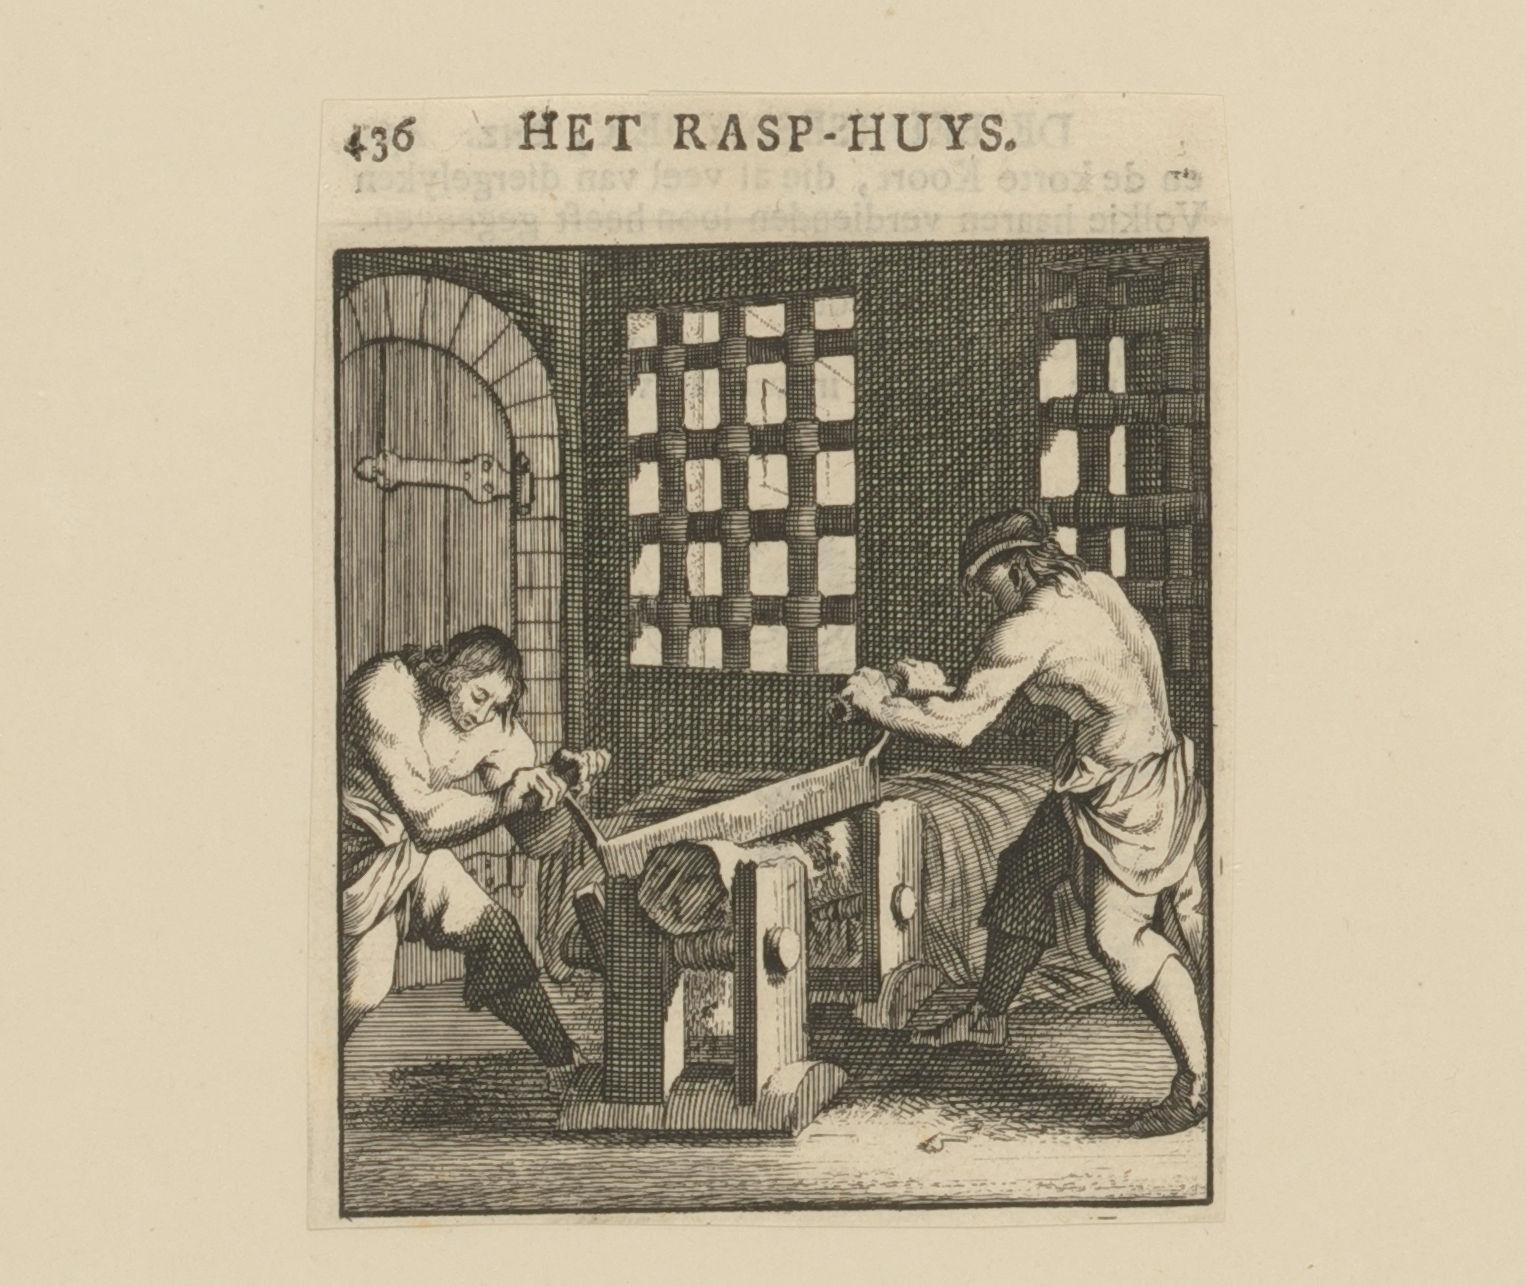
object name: print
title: Rasphuis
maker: Anonymous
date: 1719-1759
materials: paper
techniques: etching, letterpress printing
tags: criminal law; punishment, workhouse, penal camp, penitentiary, chain gang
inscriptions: collector's mark: Lugt 1641, stamp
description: Prent met andere letterzetting gebruikt in: St. Clara, Abraham van. Iets voor allen. [Vertaald door] J. le Long. Amsterdam: Janssoons van Waesberge, 1719, dl. 2. En in: St. Clara, Abraham van. Iets voor allen. [Vertaald door] J. le Long. Amsterdam: Jan Roman de Jonge, 1741, dl. 2. En in: St. Clara, Abraham van. Iets voor allen. [Vertaald door] J. le Long. Amsterdam: Jan Roman, 1759, dl. 2. Huidige prent uit een andere editie. Naar een prent van: Jan Luyken.